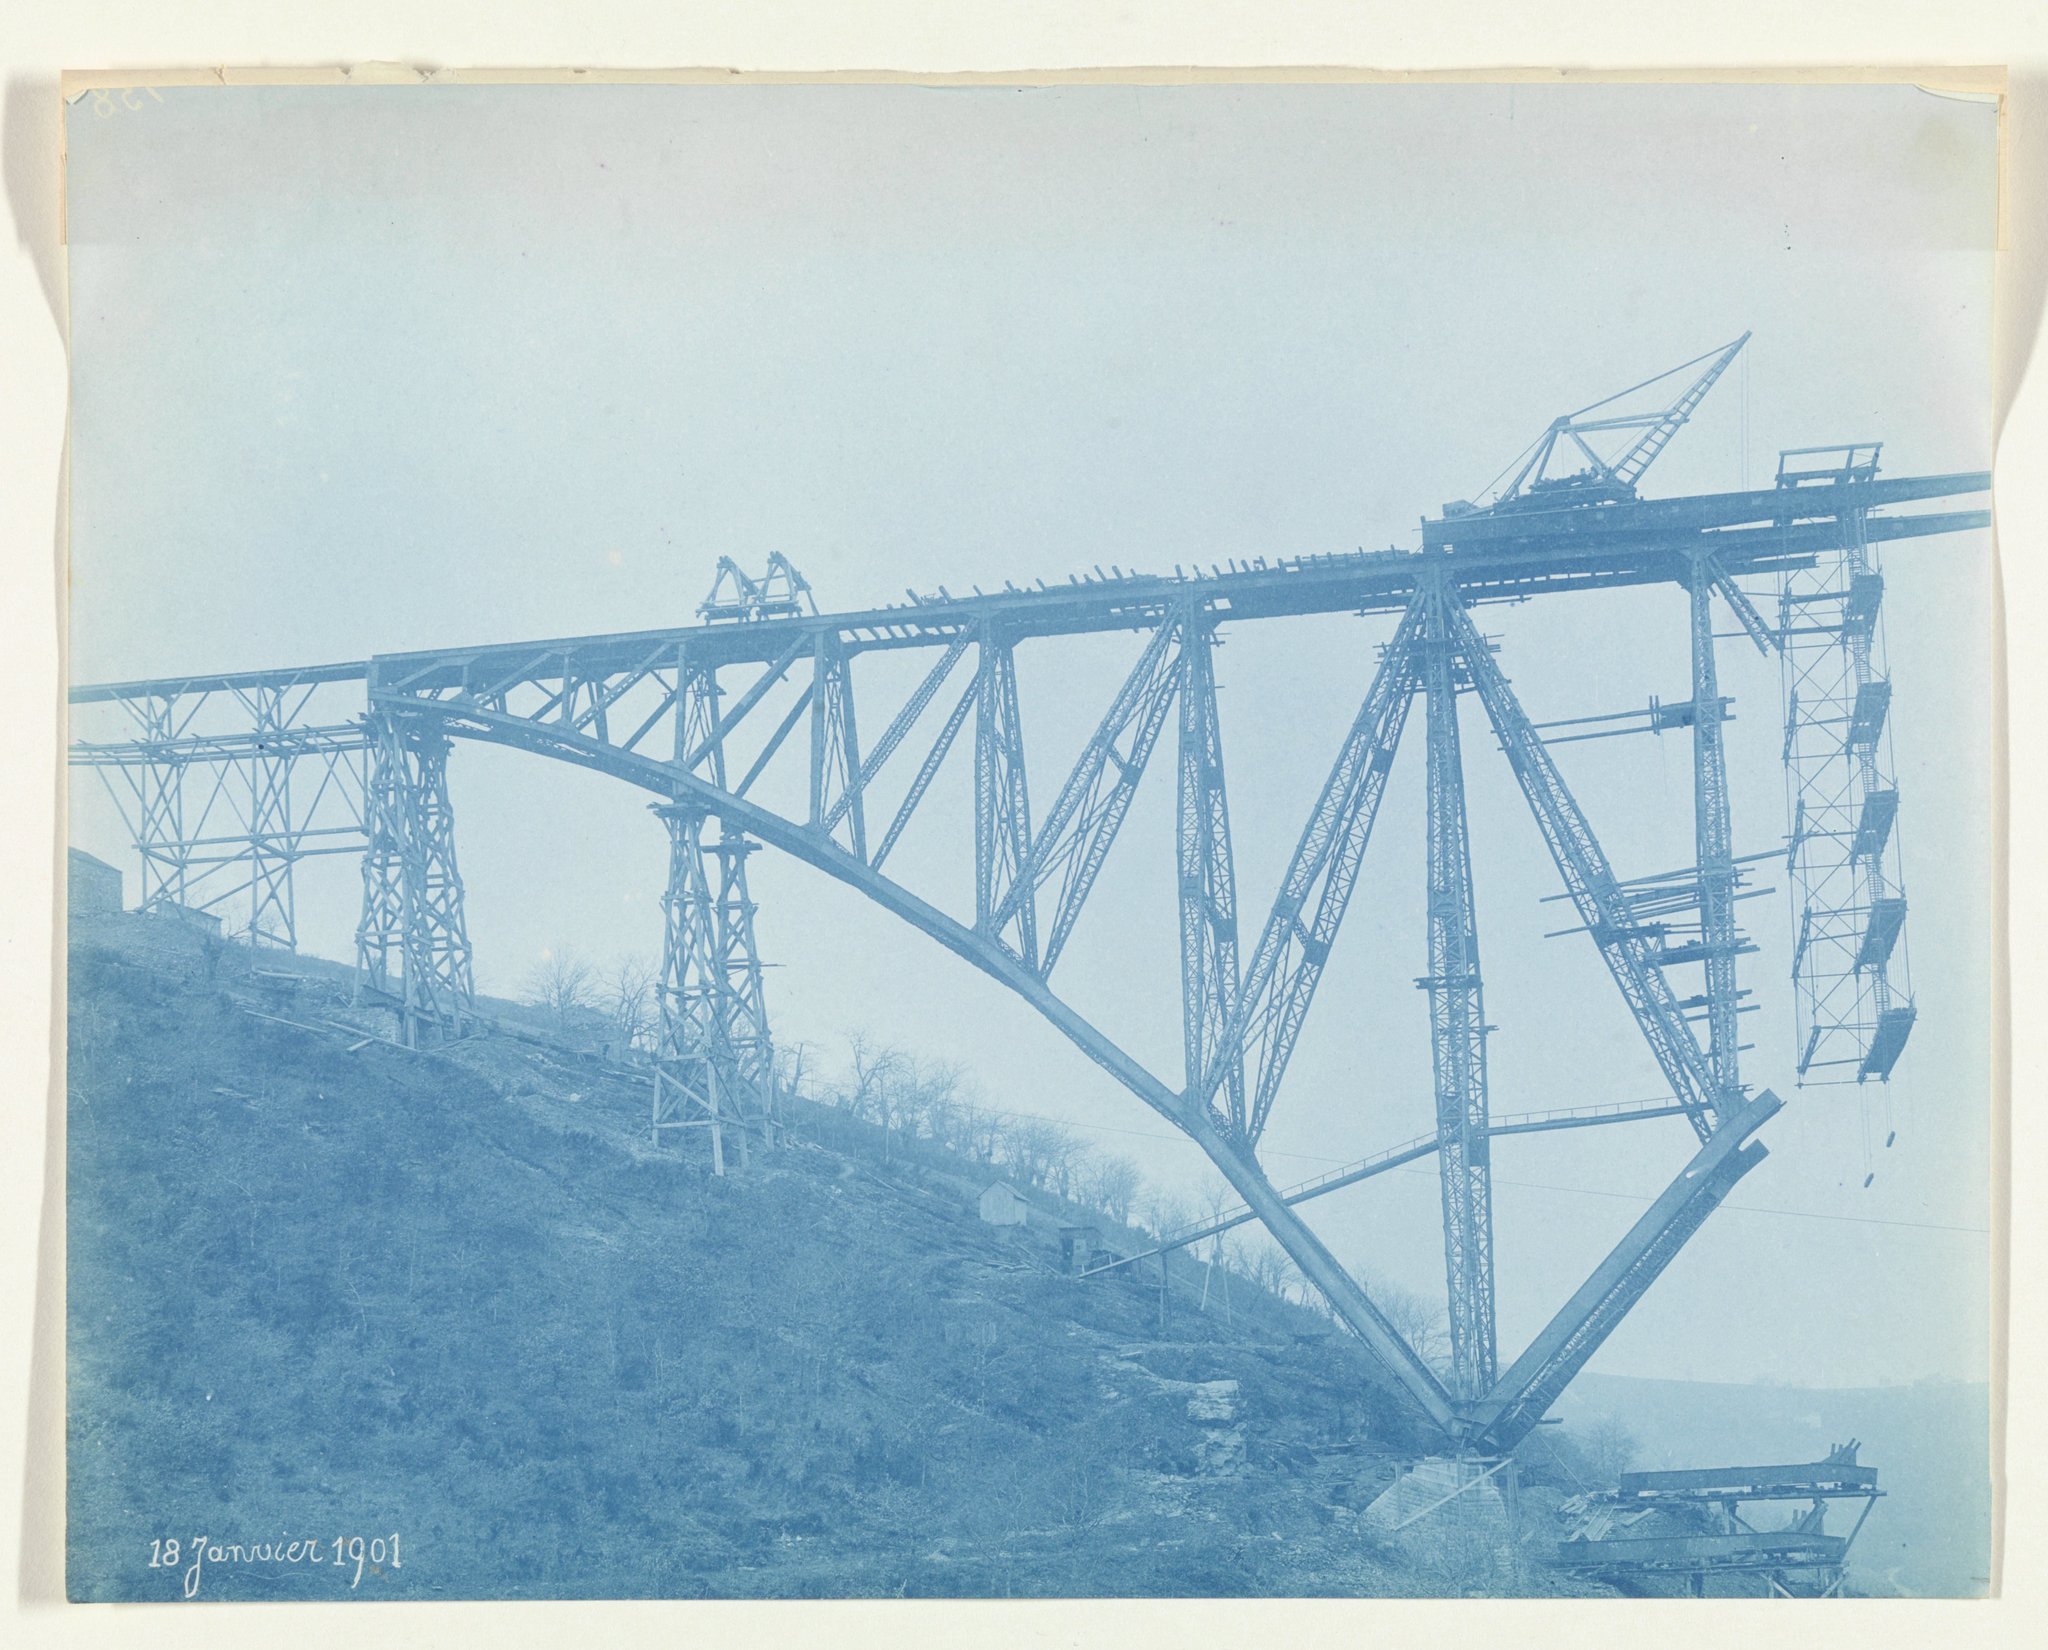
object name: photograph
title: Aanleg van het Viaur Viaduct in Frankrijk door de Societé de Construction des Battignolles, 18 januari 1901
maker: Anonymous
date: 1901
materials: photographic support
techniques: cyanotype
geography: france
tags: viaduct, making the overground structures (~ building activities)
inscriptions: inscription: ‘128’